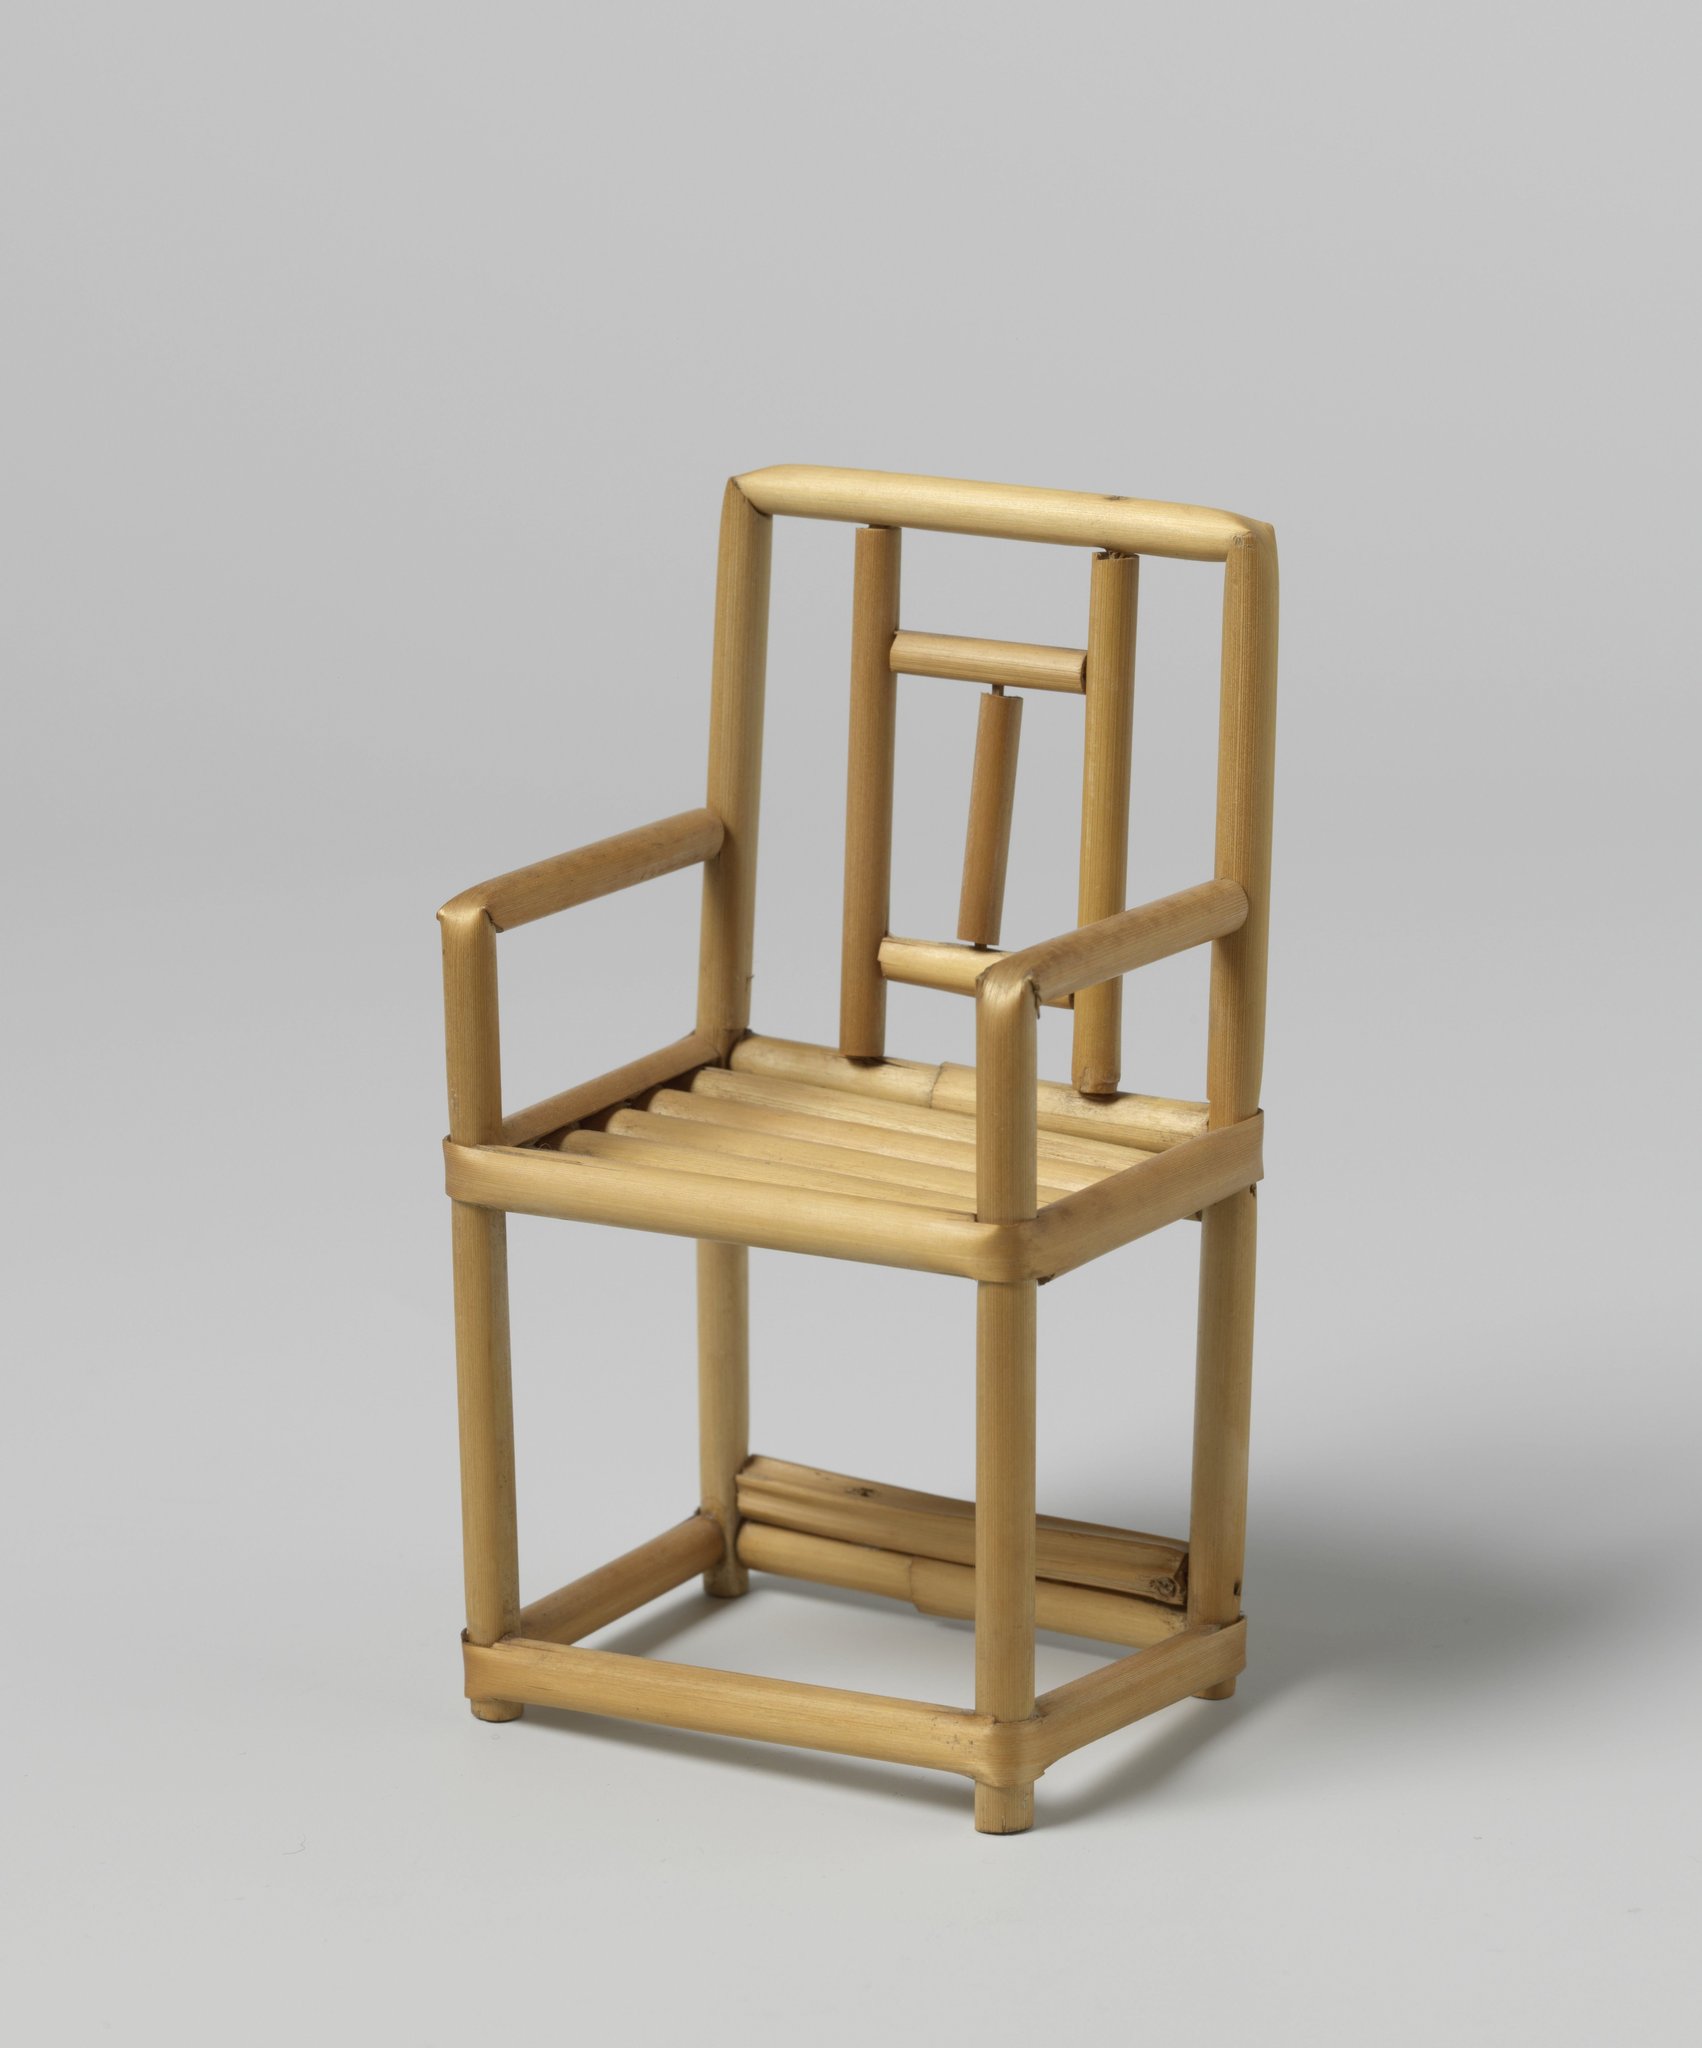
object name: chair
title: Stoel van vlechtwerk, met geometrische motieven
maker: Anonymous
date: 1800-1899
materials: wood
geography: england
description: Stoel vervaardigd van gebogen, en op houten pennetjes geregen staafjes Kleine lisdodde (Phragmites australis). De rugleuning met geometrische motieven. De poten zijn onderling verbonden met dwarsregels. De zitting is vervaardigd van vijf in de breedte bevestigde gehalveerde stengels.